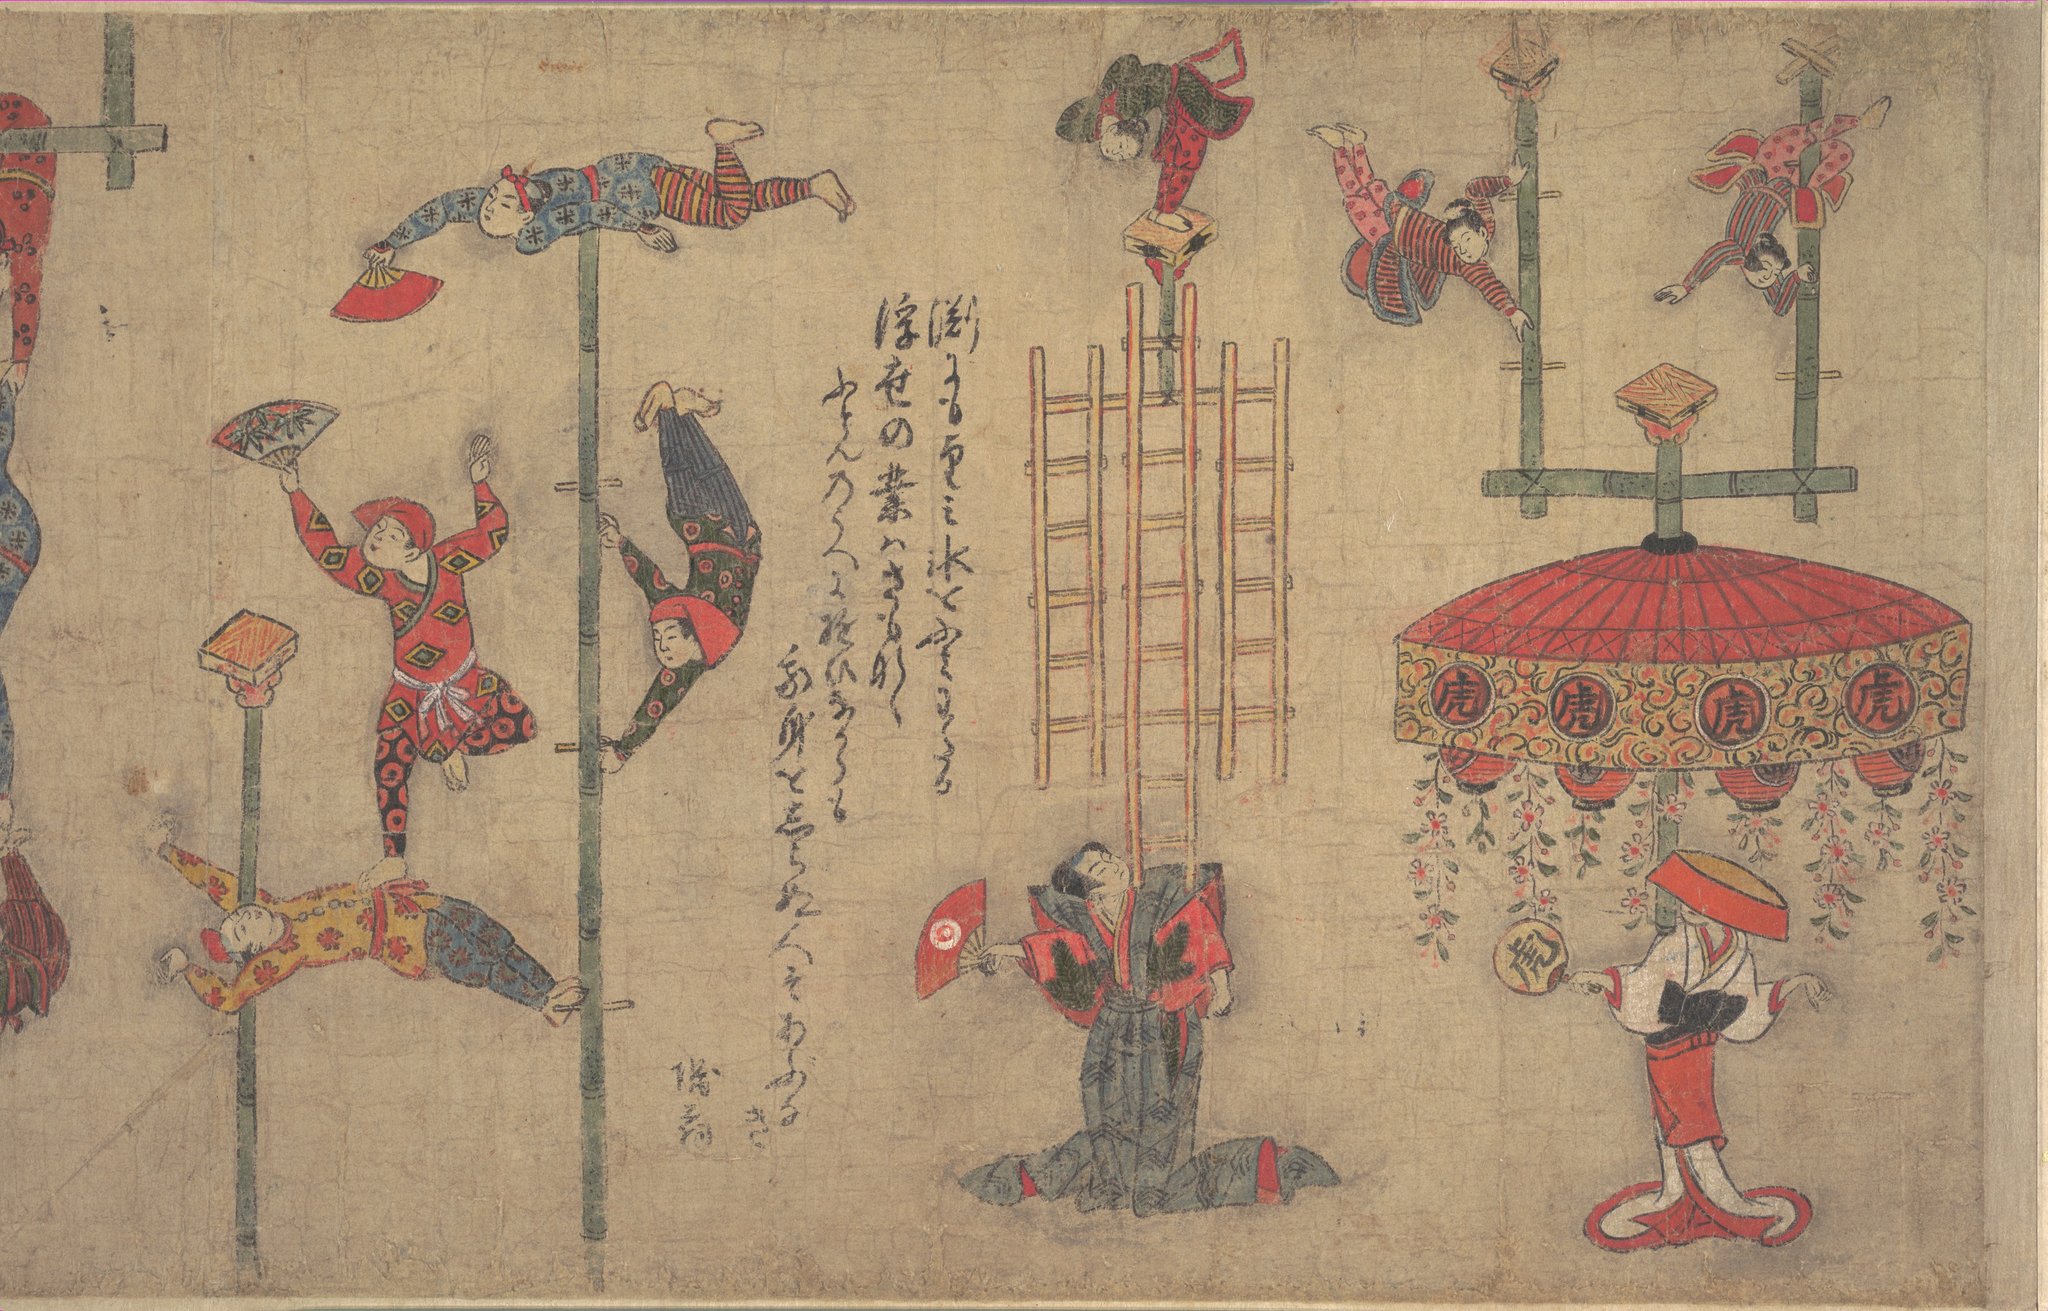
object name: handscroll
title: Acrobats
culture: japanese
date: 1800-1809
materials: ink, paper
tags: acrobats,ladders